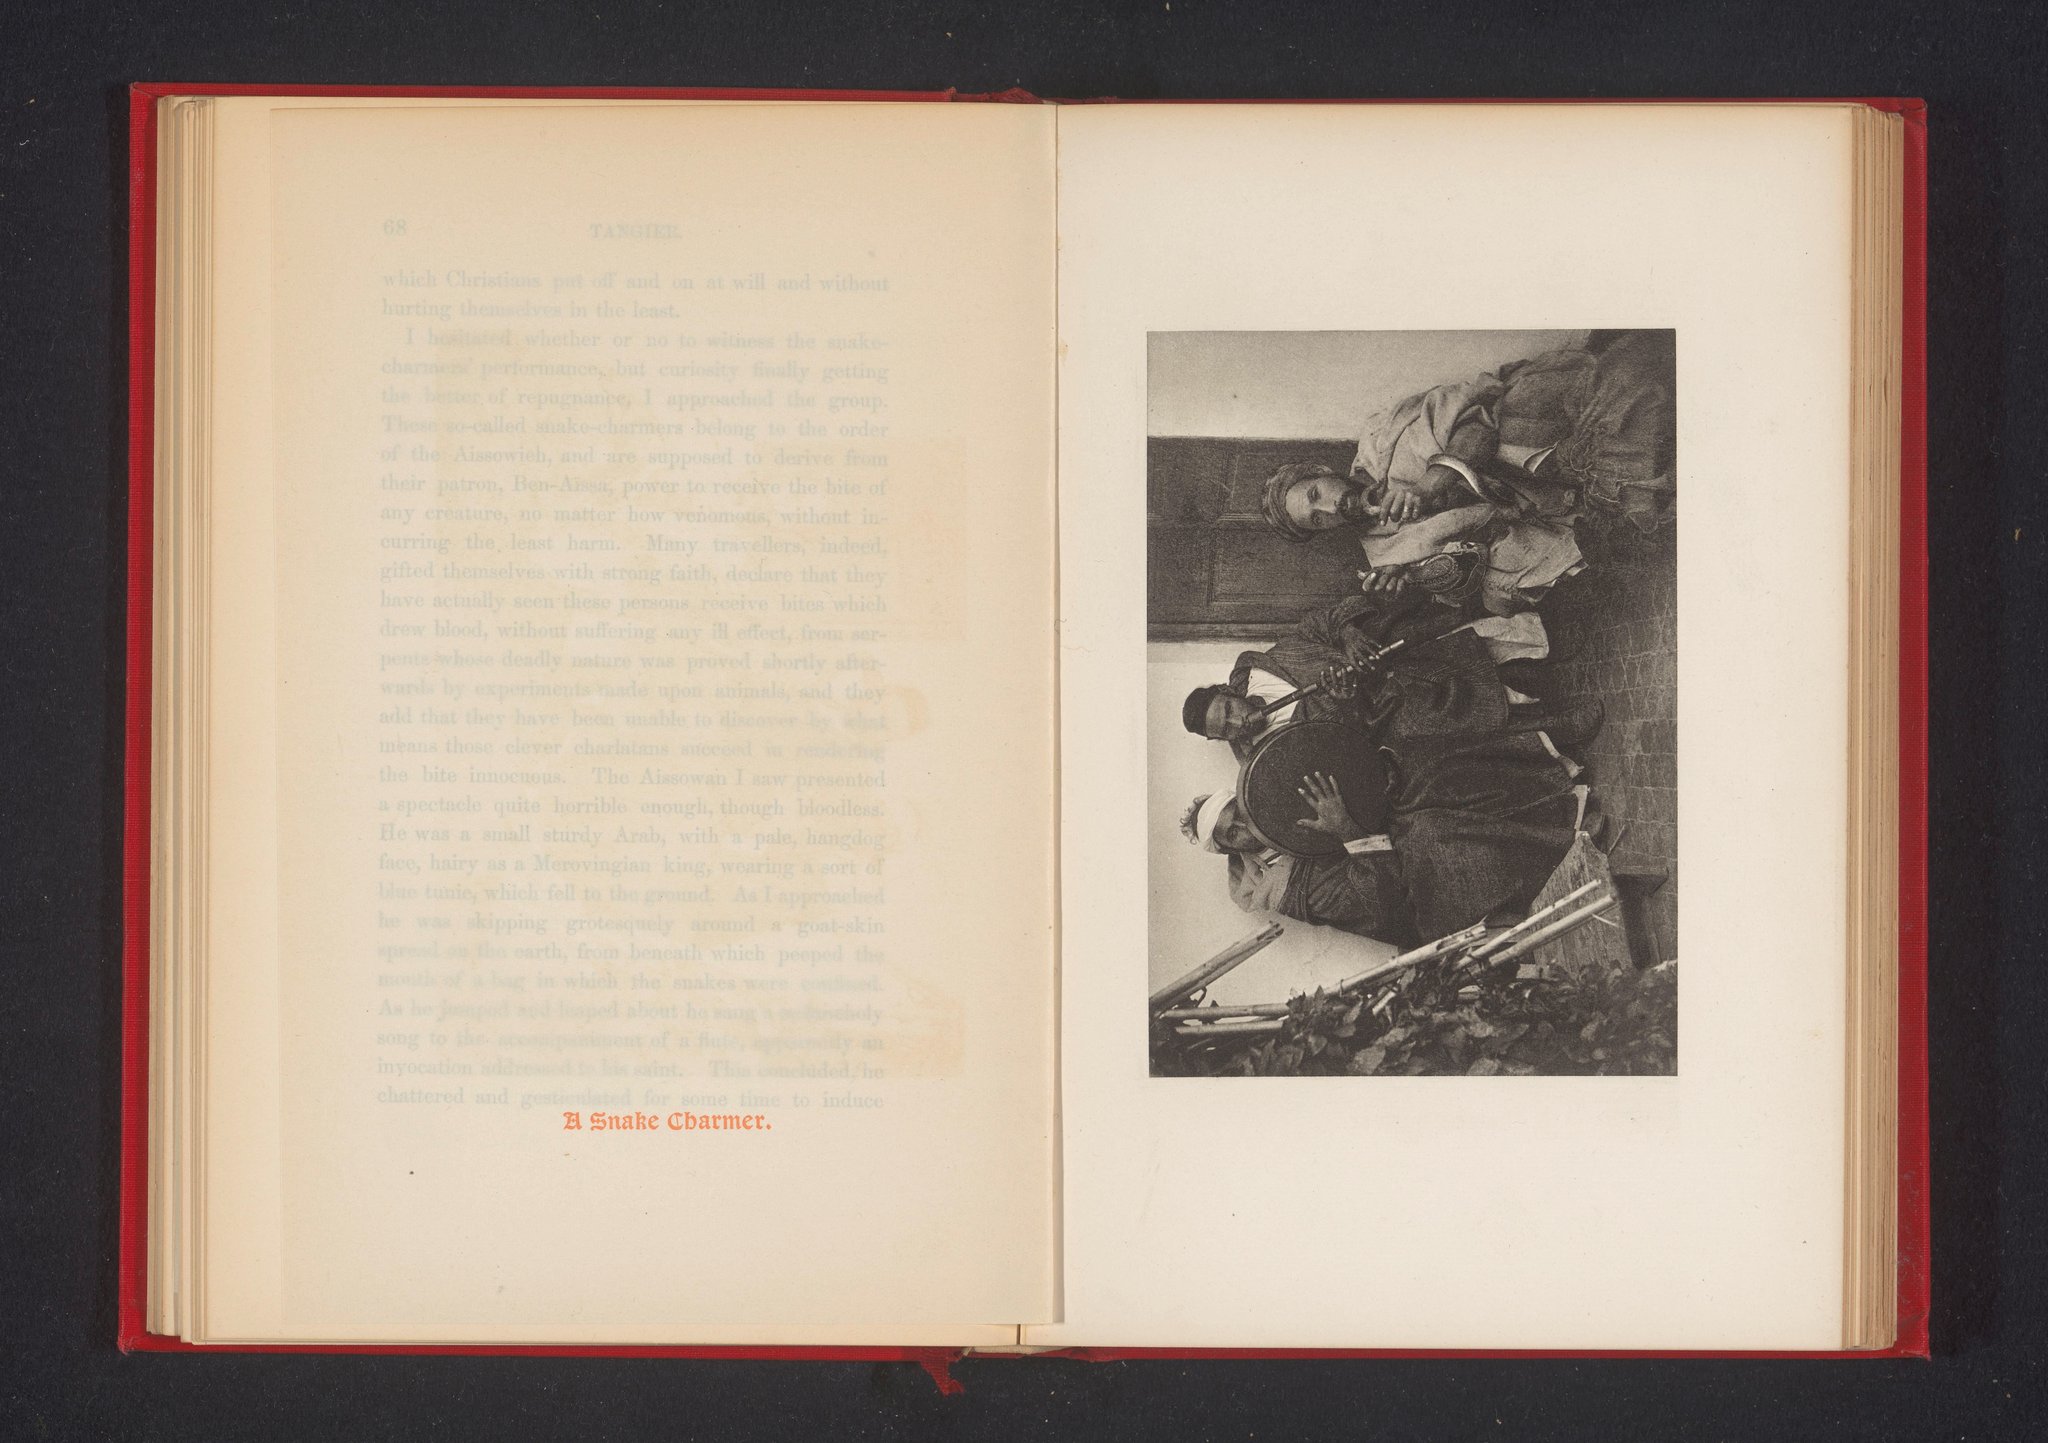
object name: photomechanical print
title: Slangenbezweerder te Tanger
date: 1887-1897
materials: paper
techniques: photoaquatint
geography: tanger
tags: snakes, adult man, flute, aulos, tibia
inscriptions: title: ‘A Snake Charmer.’